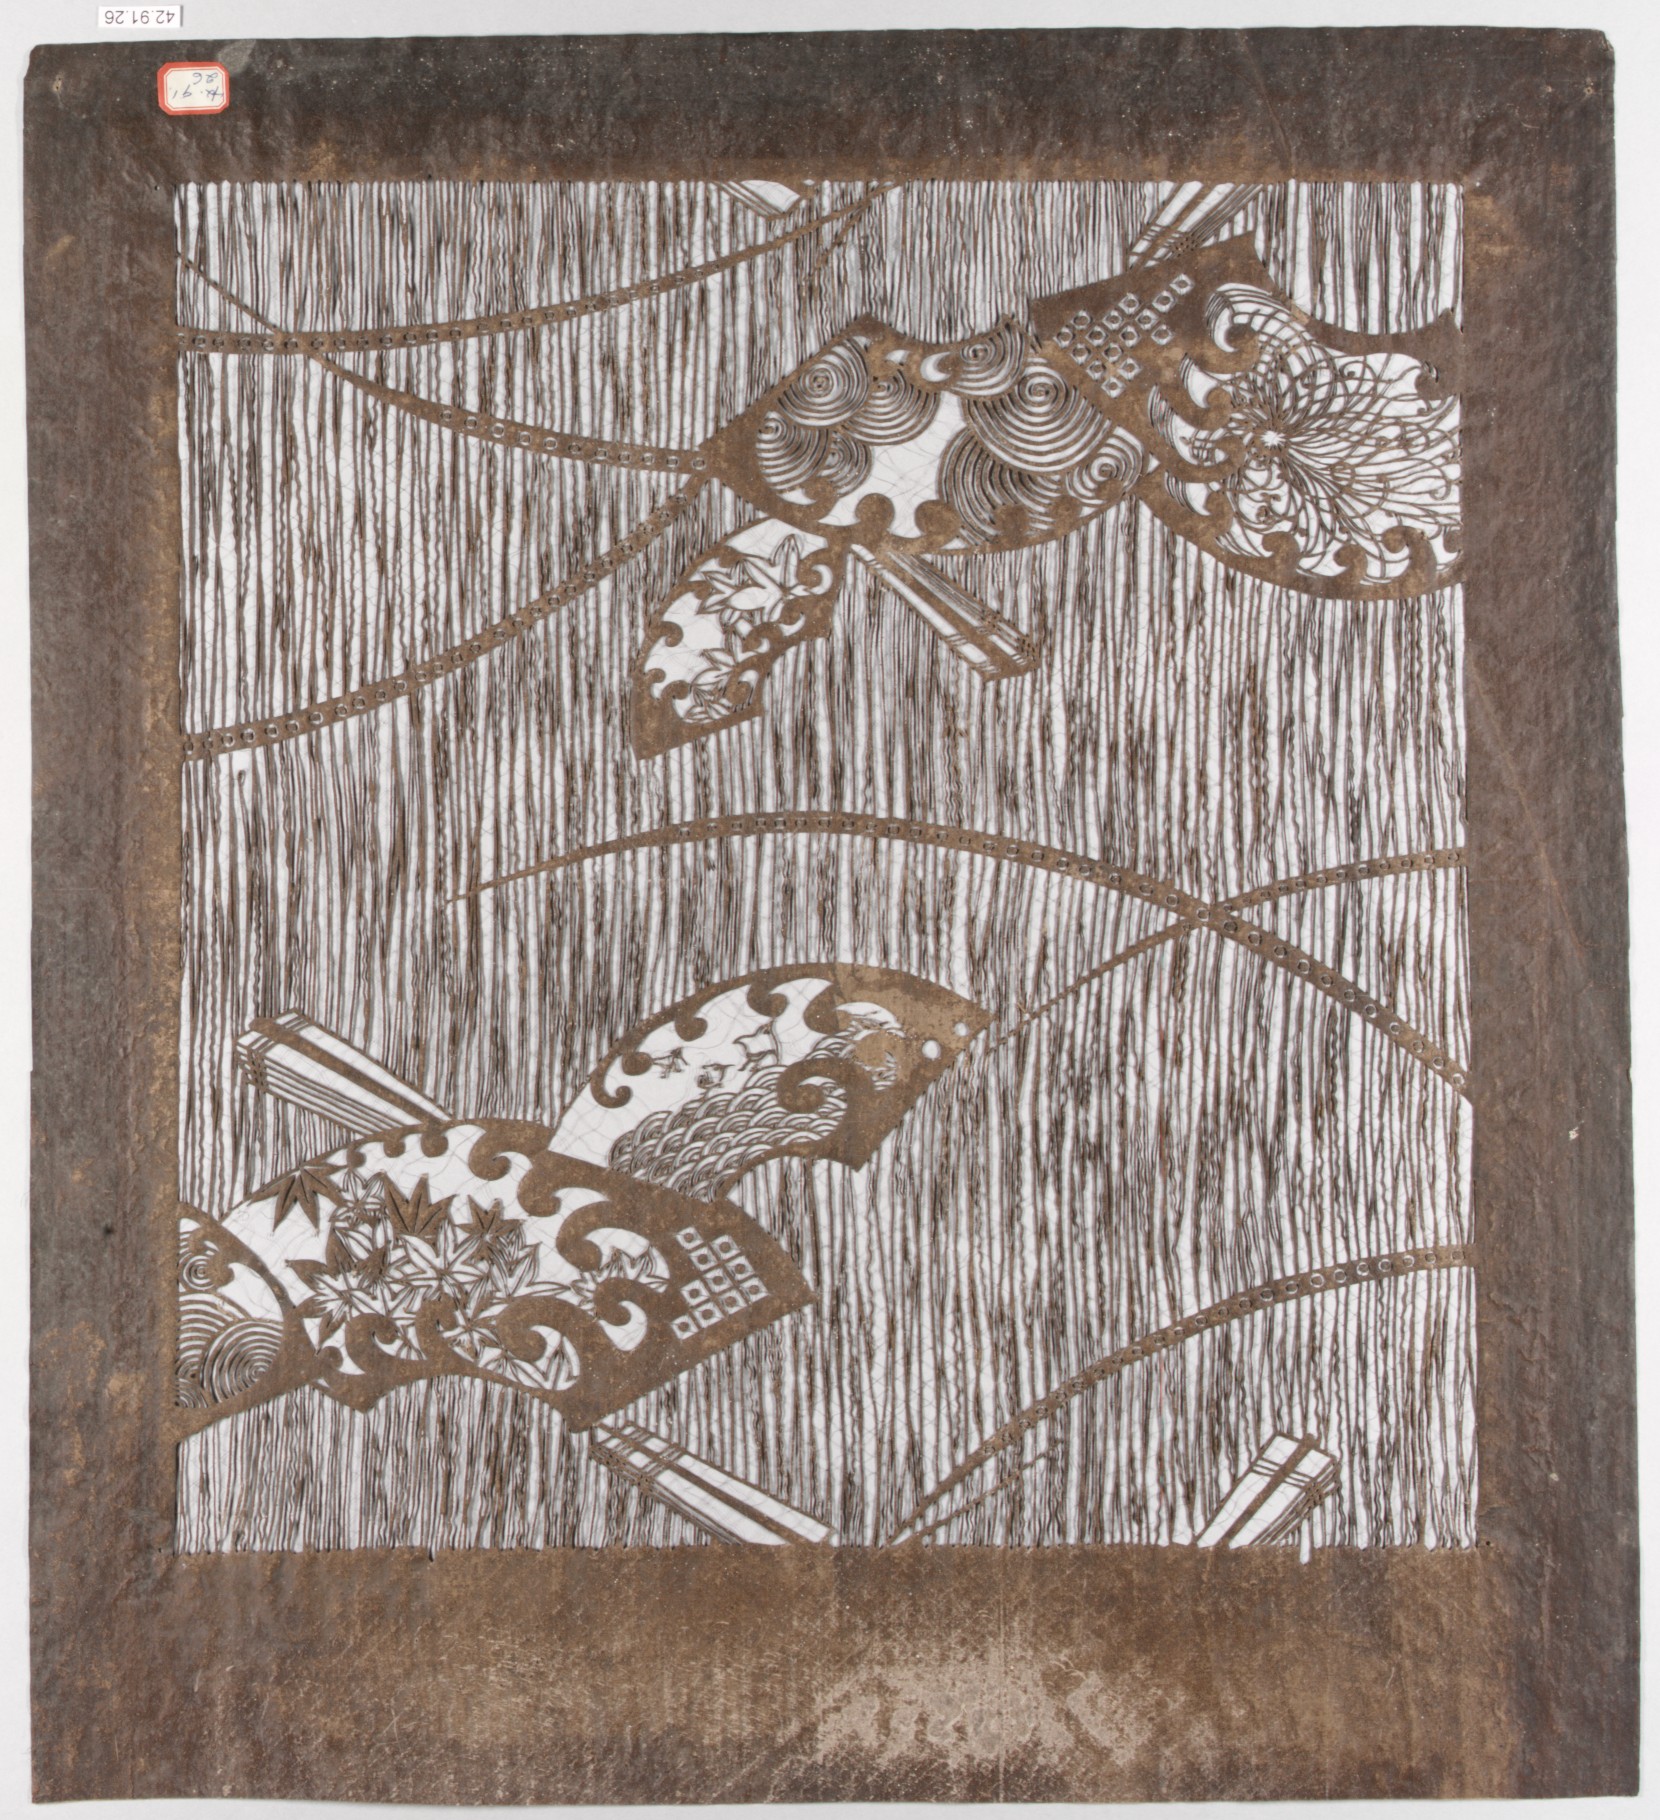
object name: stencil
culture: japanese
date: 1801-1900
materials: paper, silk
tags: fans